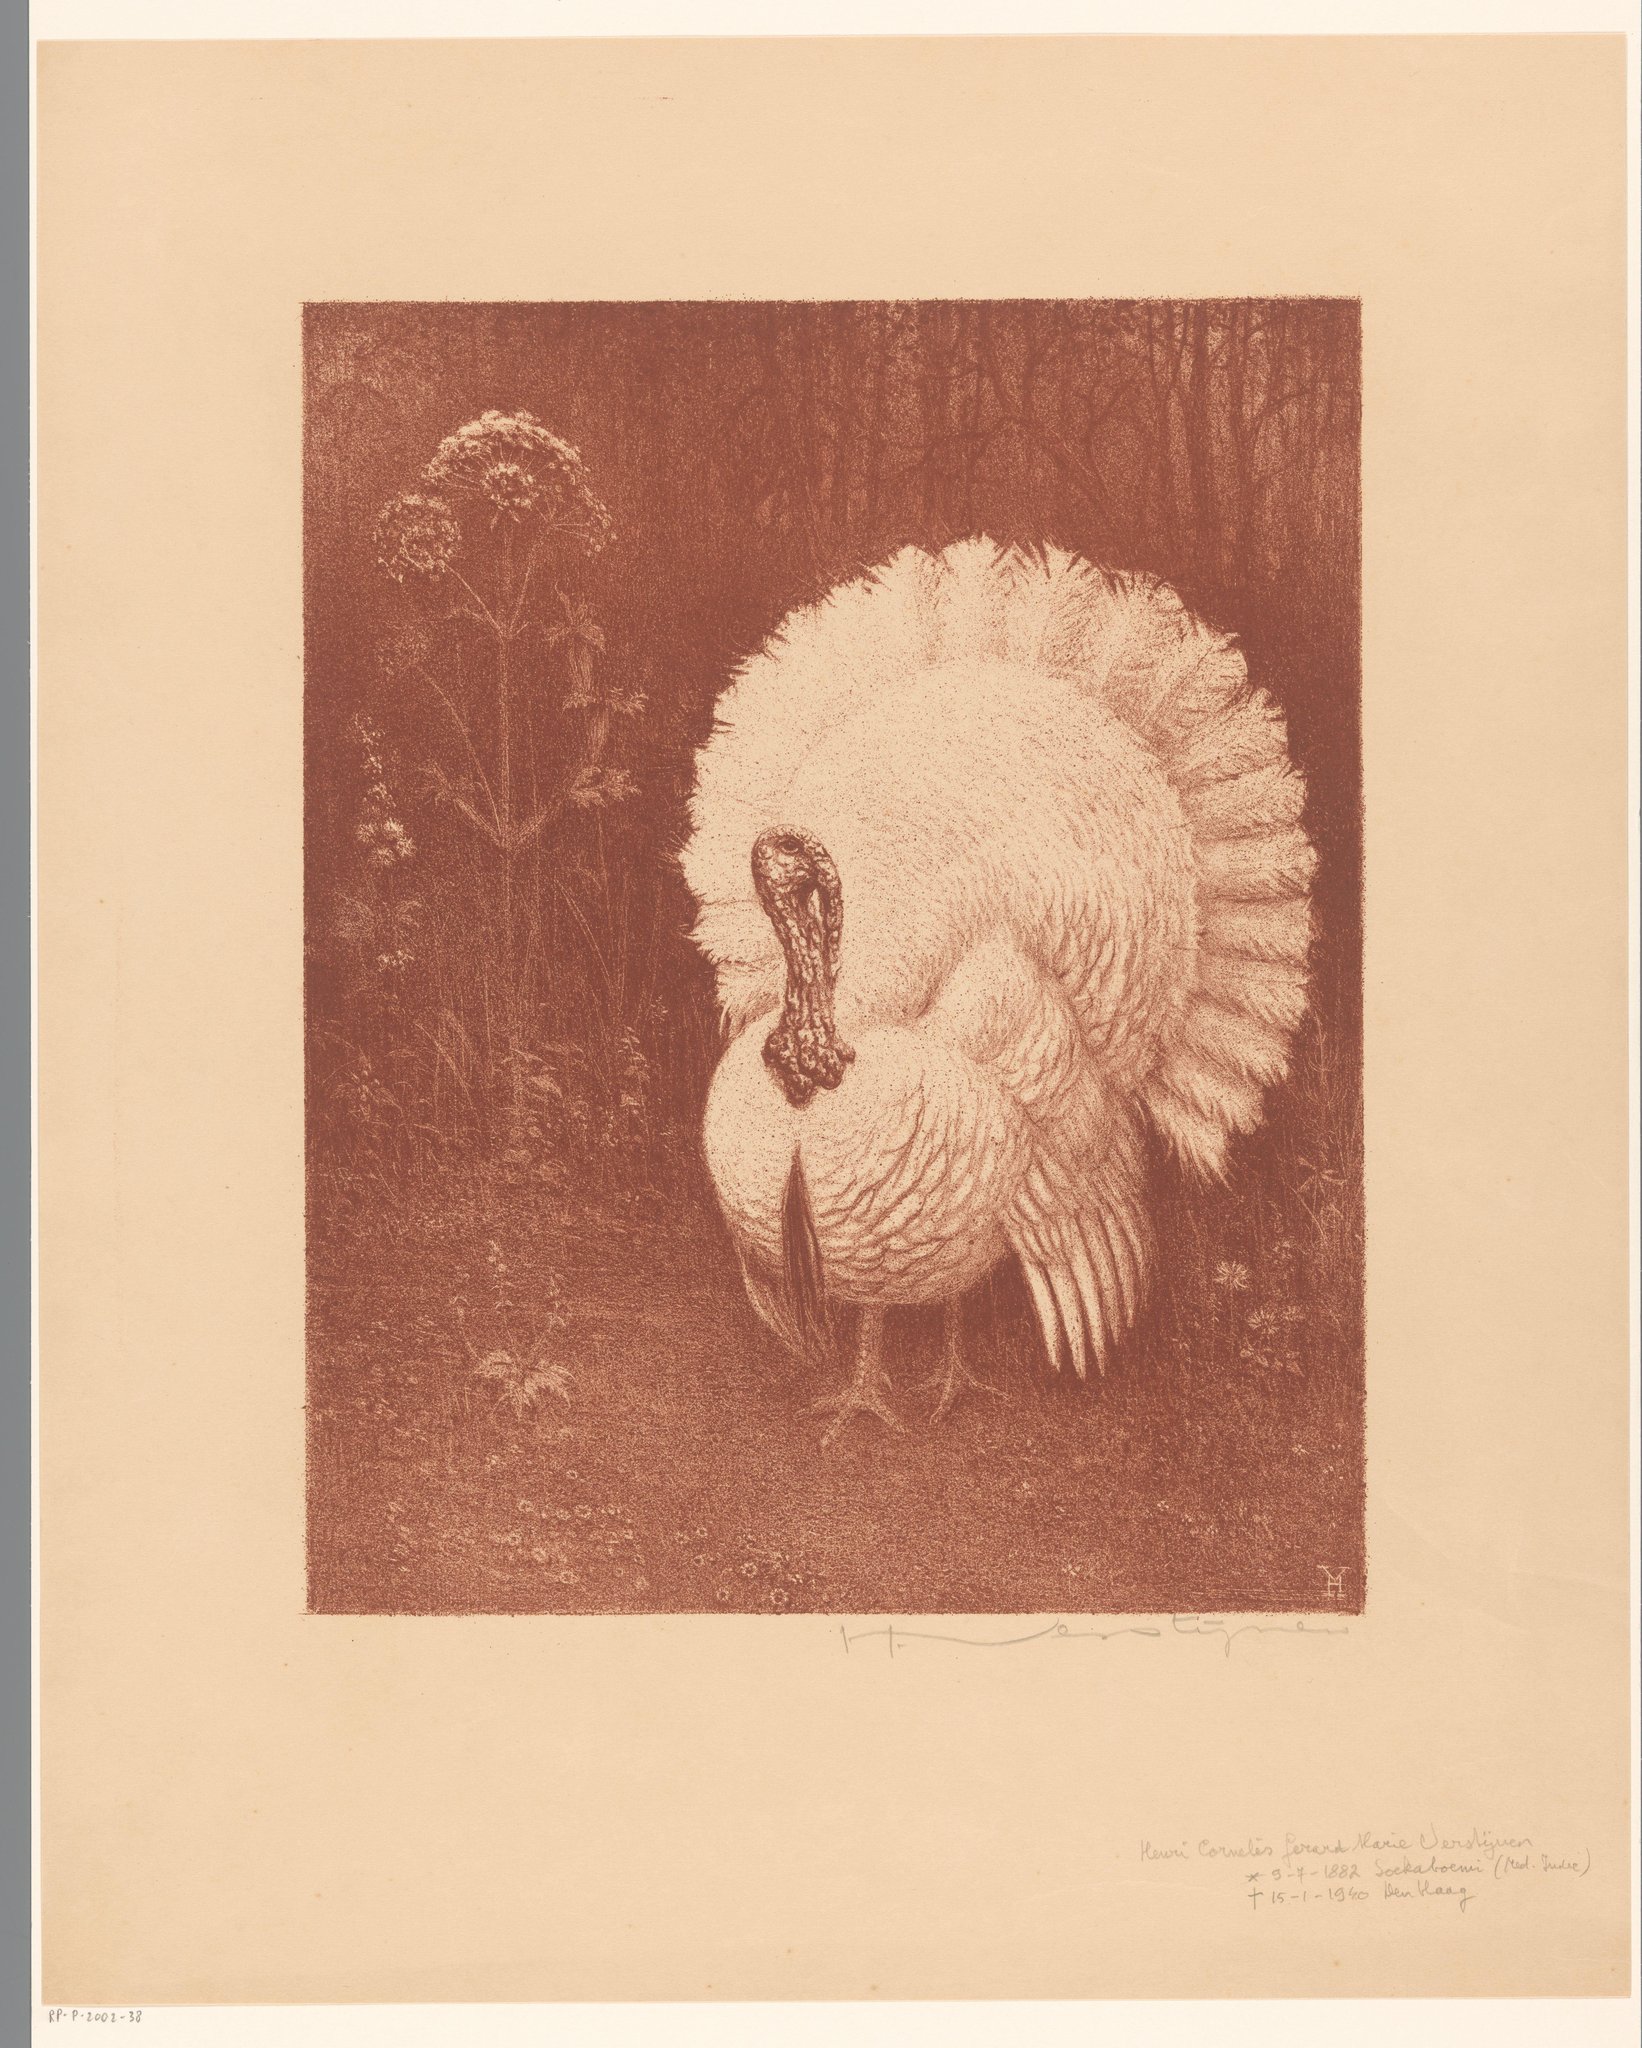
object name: print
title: Kalkoen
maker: henri verstijnen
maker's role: draughtsman, print maker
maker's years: 1882-1940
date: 1892-1940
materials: paper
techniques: lithograph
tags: walker and runner birds: turkey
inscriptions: collector's mark: 2760, collector's mark: ‘qJh’, collector's mark: Lugt 2228